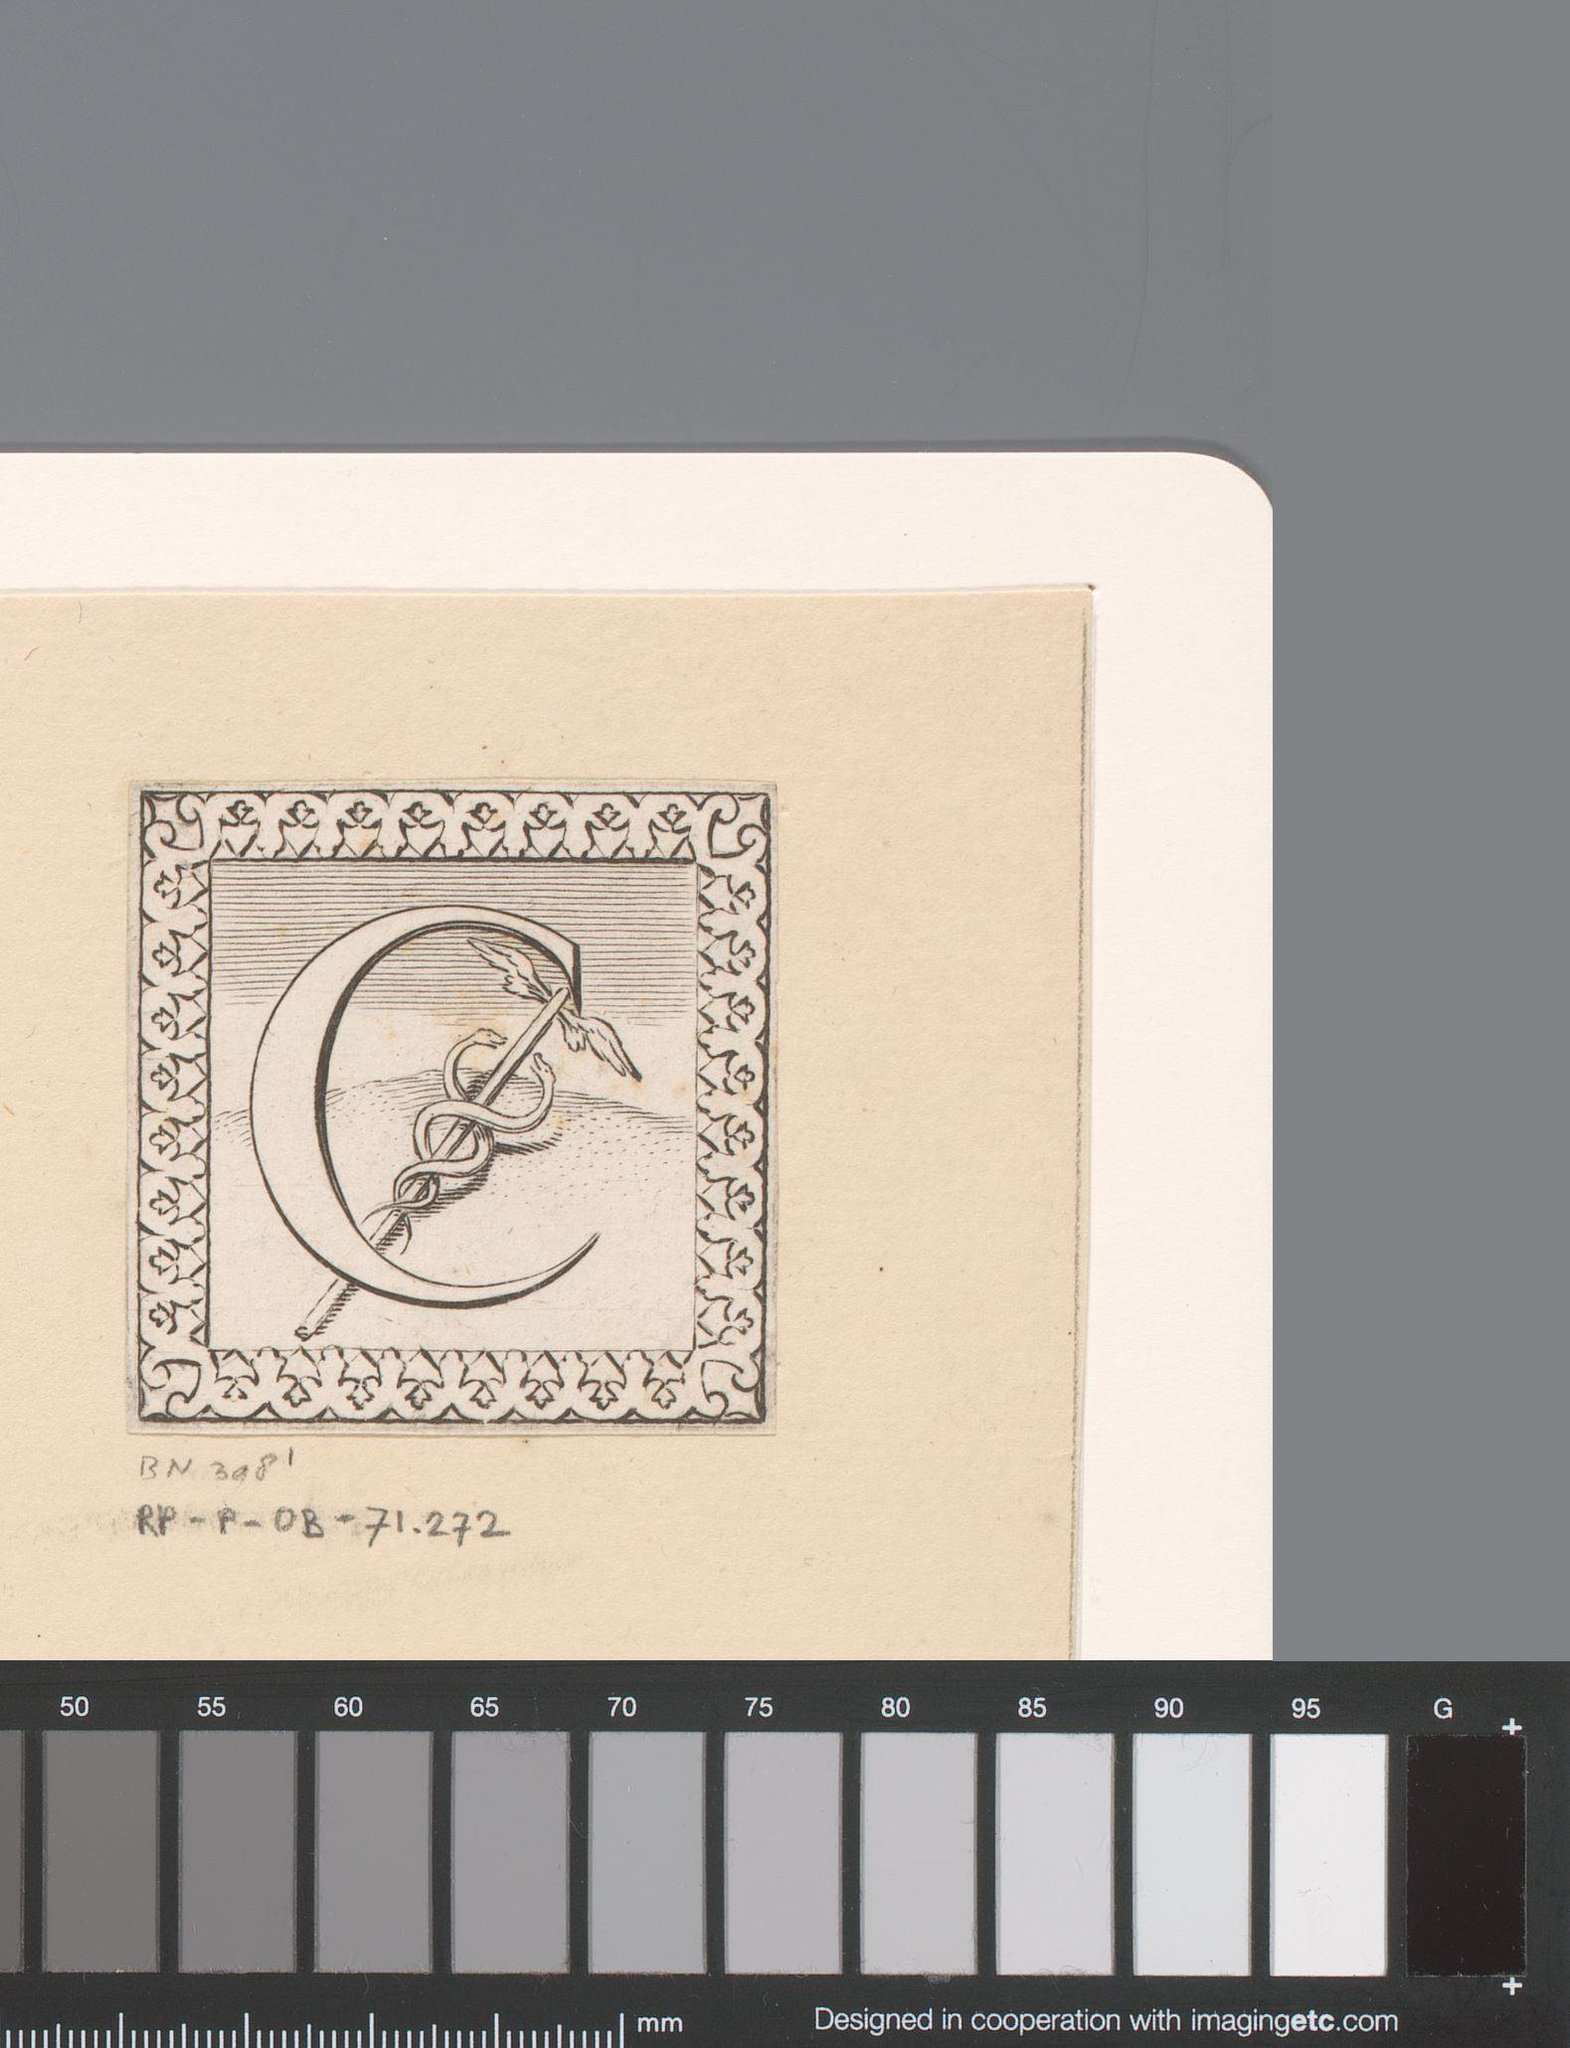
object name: print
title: Letter C met caduceus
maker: claude mellan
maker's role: draughtsman, print maker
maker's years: 1598-1688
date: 1639-1643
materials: paper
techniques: engraving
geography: paris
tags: decoration of printed matter, letters, alphabet, script, caduceus (staff with two snakes, attribute of mercury)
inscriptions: collector's mark: Lugt 240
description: Dit betreft één van de 21 letters die Mellan voor de Imprimerie Royale vervaardigde. Elke letter wordt vergezeld door een afbeelding van een onderwerp dat met dezelfde letter begint. Tussen 1639-1643 werkte Mellan samen met de Imprimerie Royale (IFF 17e siècle, p. 21-22). Hij vervaardigde verschillende vignetten, letters, culs-de-lampe en decoratieve banden (IFF 17e siècle, p. 215-220). O.a. gebruikt voor de publicatie: Vergilius Maro, Publius. Publii Virgilii Maronis Opera. Parijs: Imprimerie Royale, 1641. Zie IFF 17e siècle, p. 218, nr. 398.